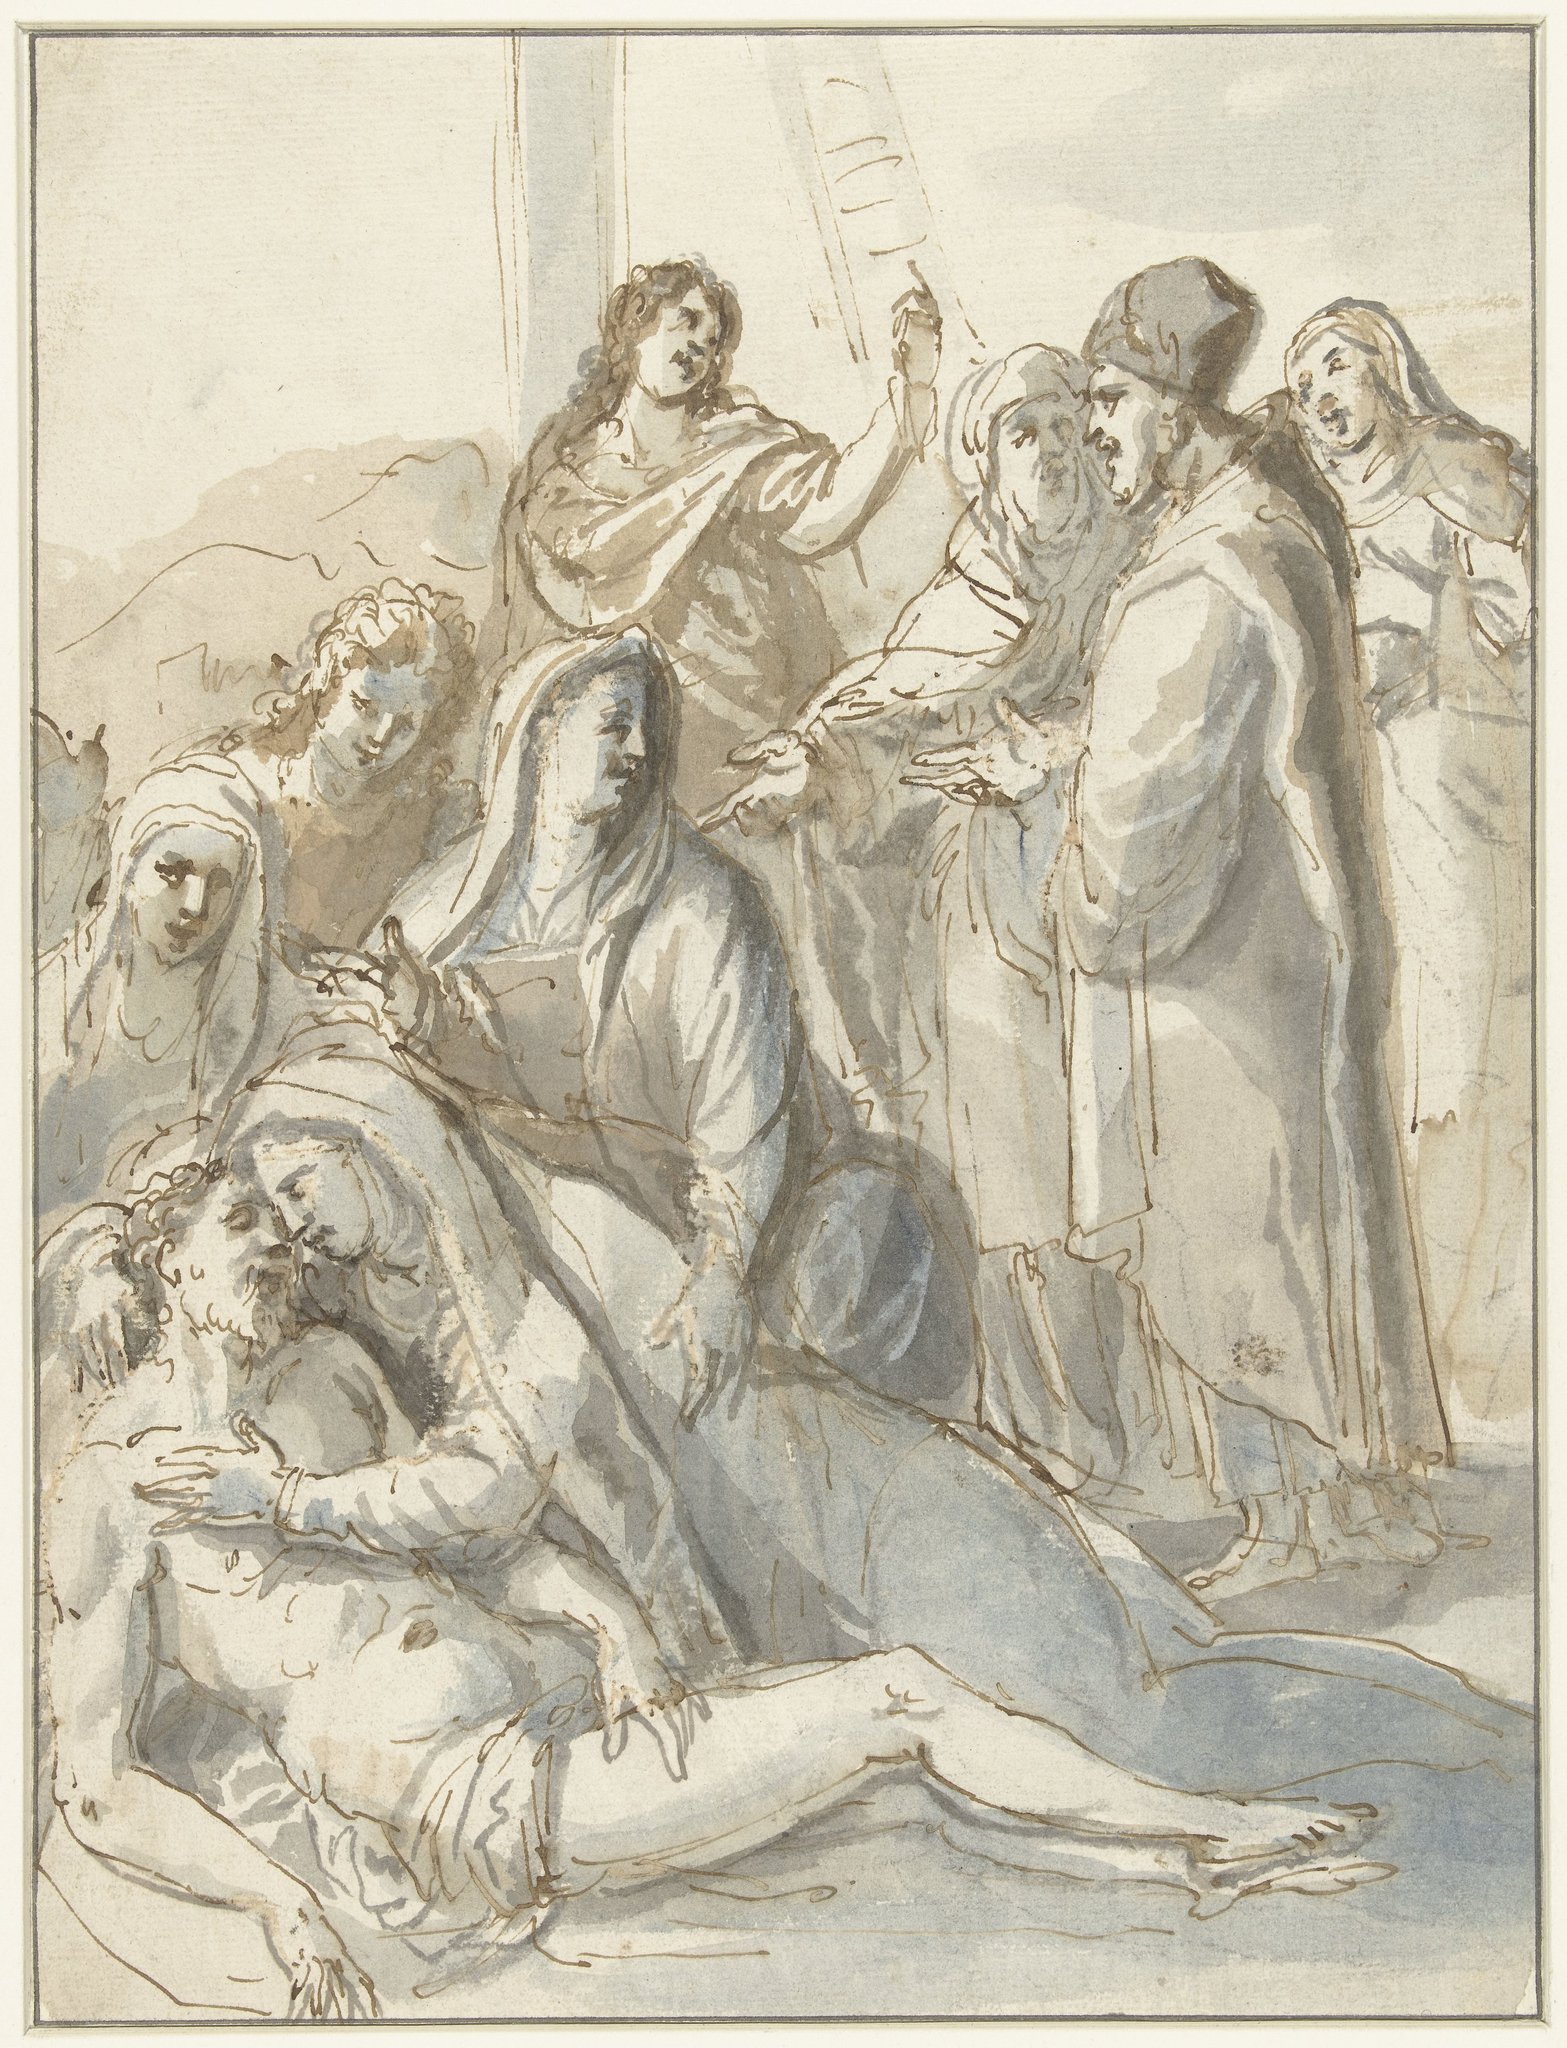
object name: drawing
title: Bewening onder het kruis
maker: Anonymous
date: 1500-1600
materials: ink, paper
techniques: brush, pen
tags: lamentation over the dead christ by his relatives and friends (christ usually without crown of thorns)